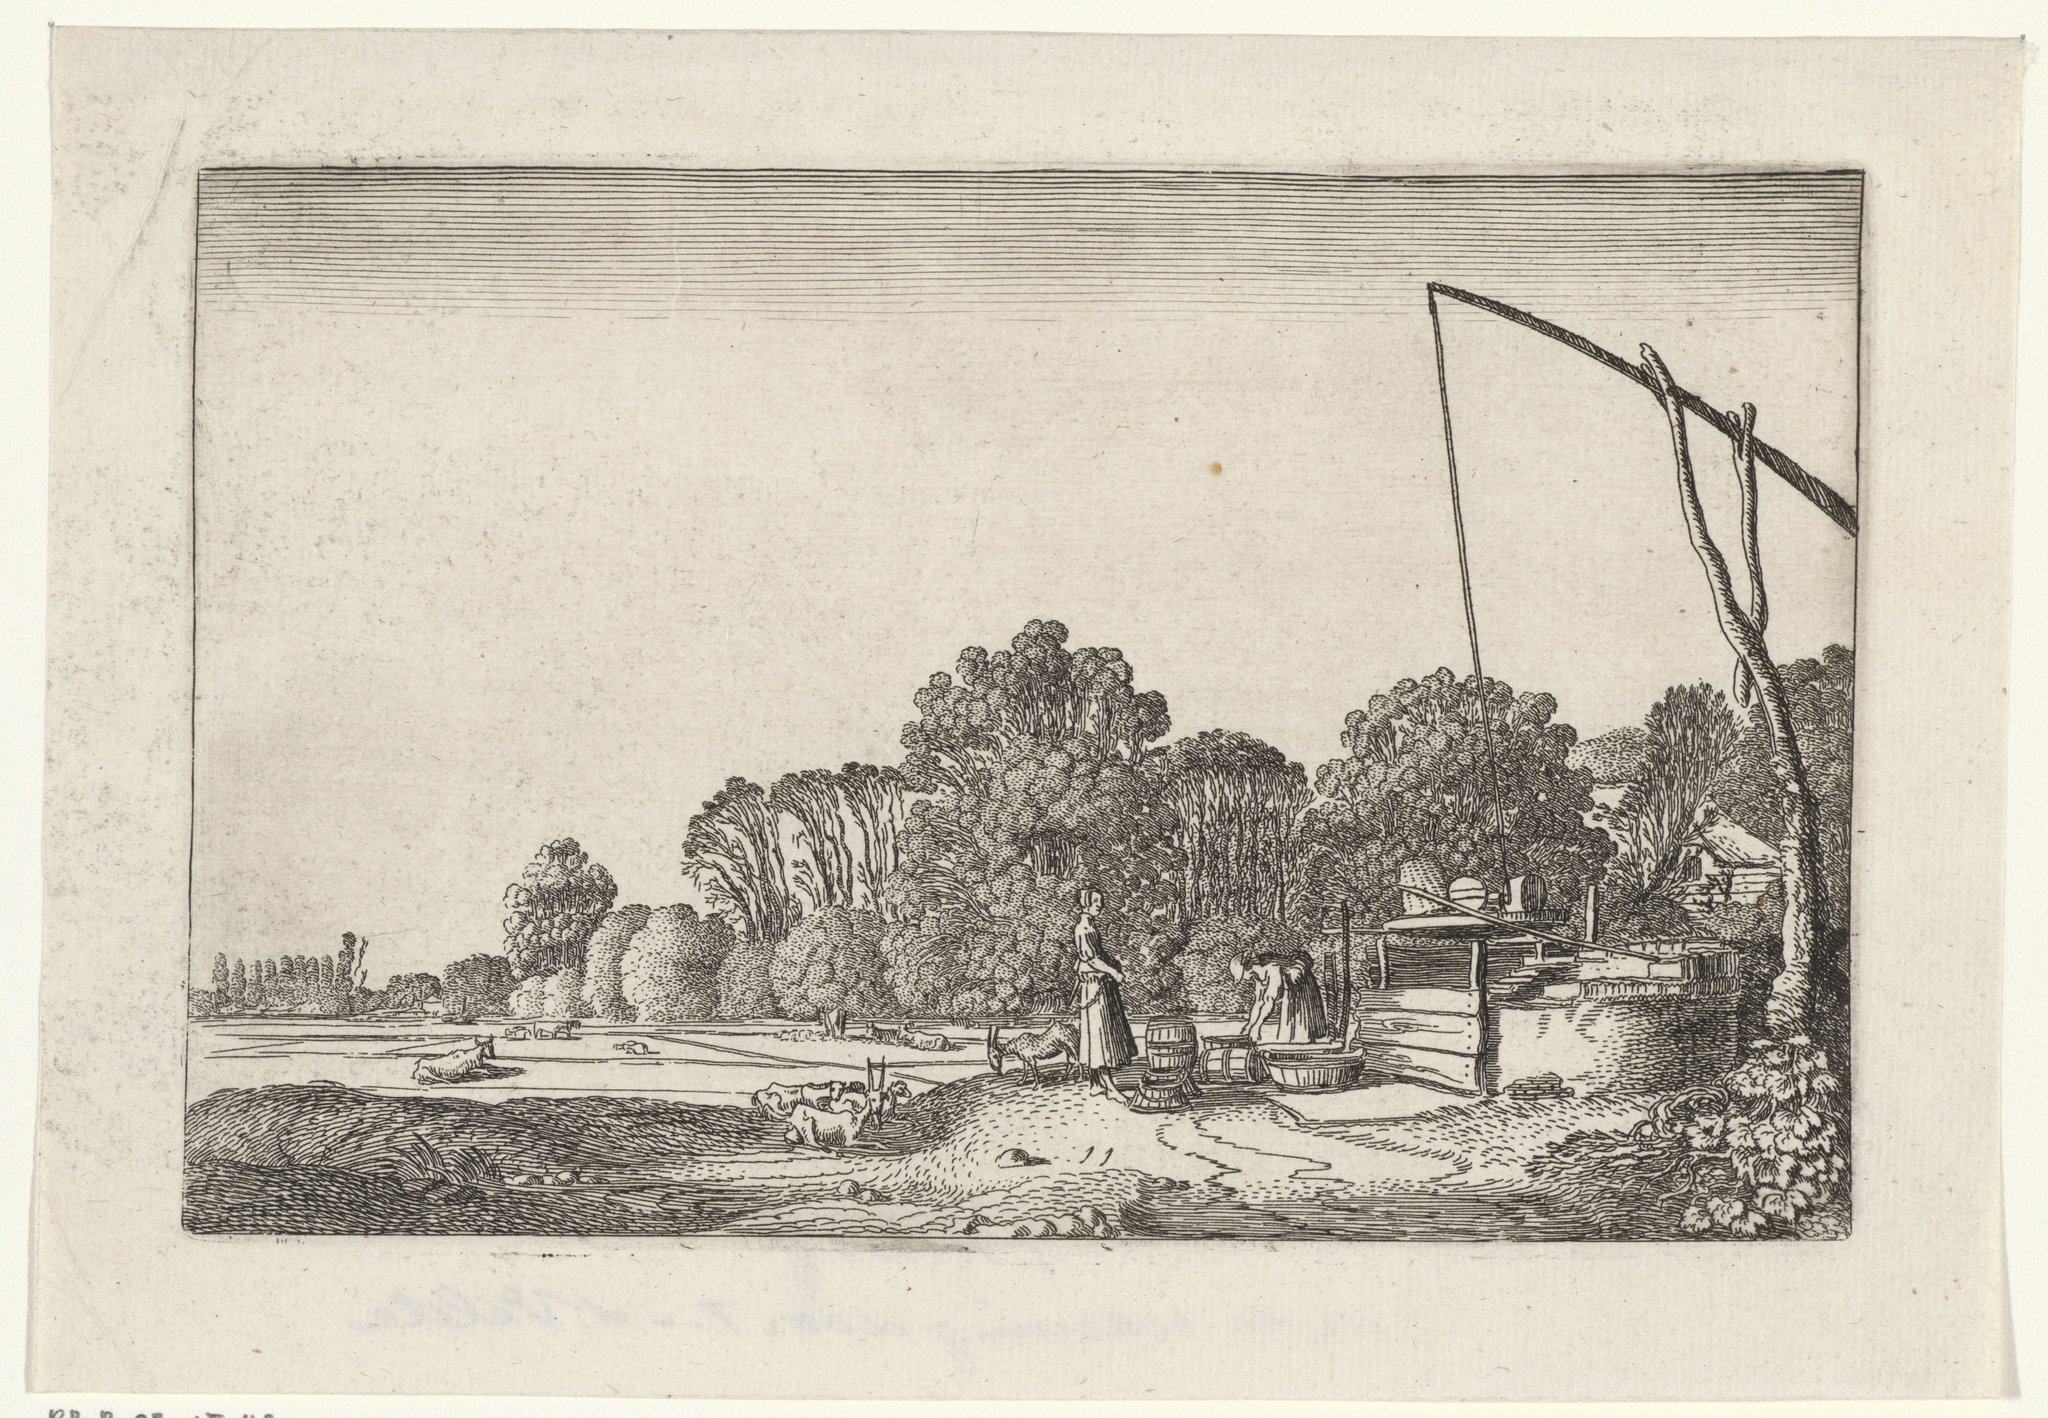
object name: print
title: Ruïnes in landschappen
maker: jan van de velde (ii)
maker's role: draughtsman, painter, print maker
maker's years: 1593-1641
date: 1616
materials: paper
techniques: etching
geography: northern netherlands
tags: well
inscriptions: collector's mark: Lugt 240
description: Twee vrouwen bij een waterput in een landschap. Elfde prent van een serie van zestien.